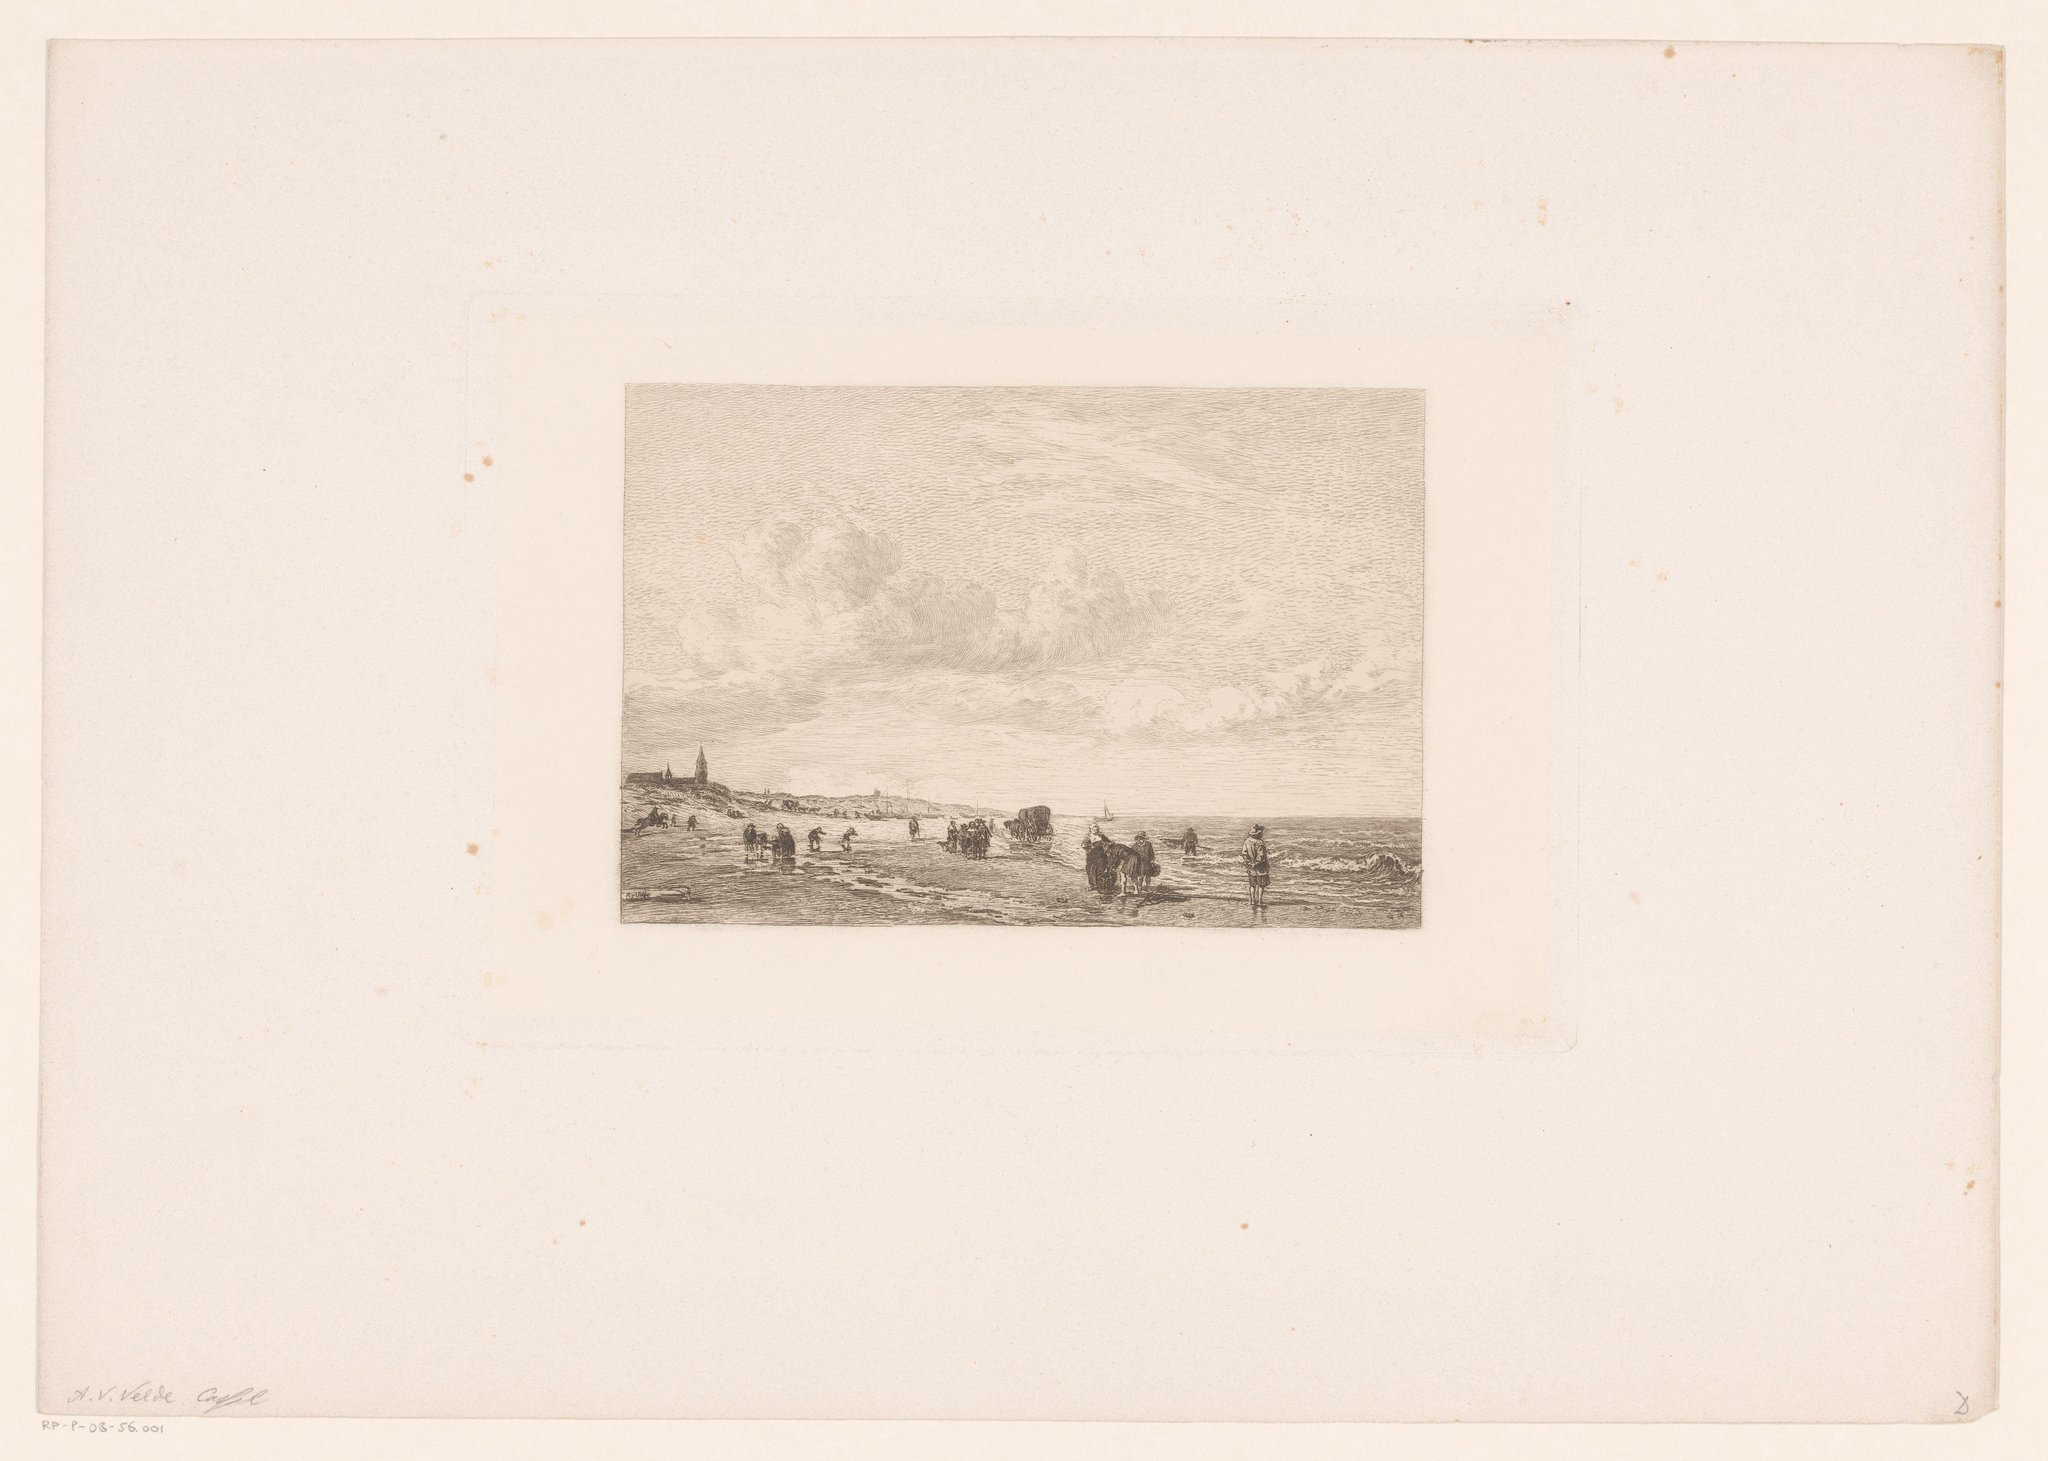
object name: print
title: Gezicht op het strand van Scheveningen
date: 1847-1889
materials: paper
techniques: etching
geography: germany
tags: building of church, four-wheeled vehicle drawn by two animals, beach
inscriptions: collector's mark: Lugt 2228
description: Prent naar het schilderij door Adriaen van de Velde in de Gemäldegalerie Alte Meister te Kassel (inv.nr. GK 374).